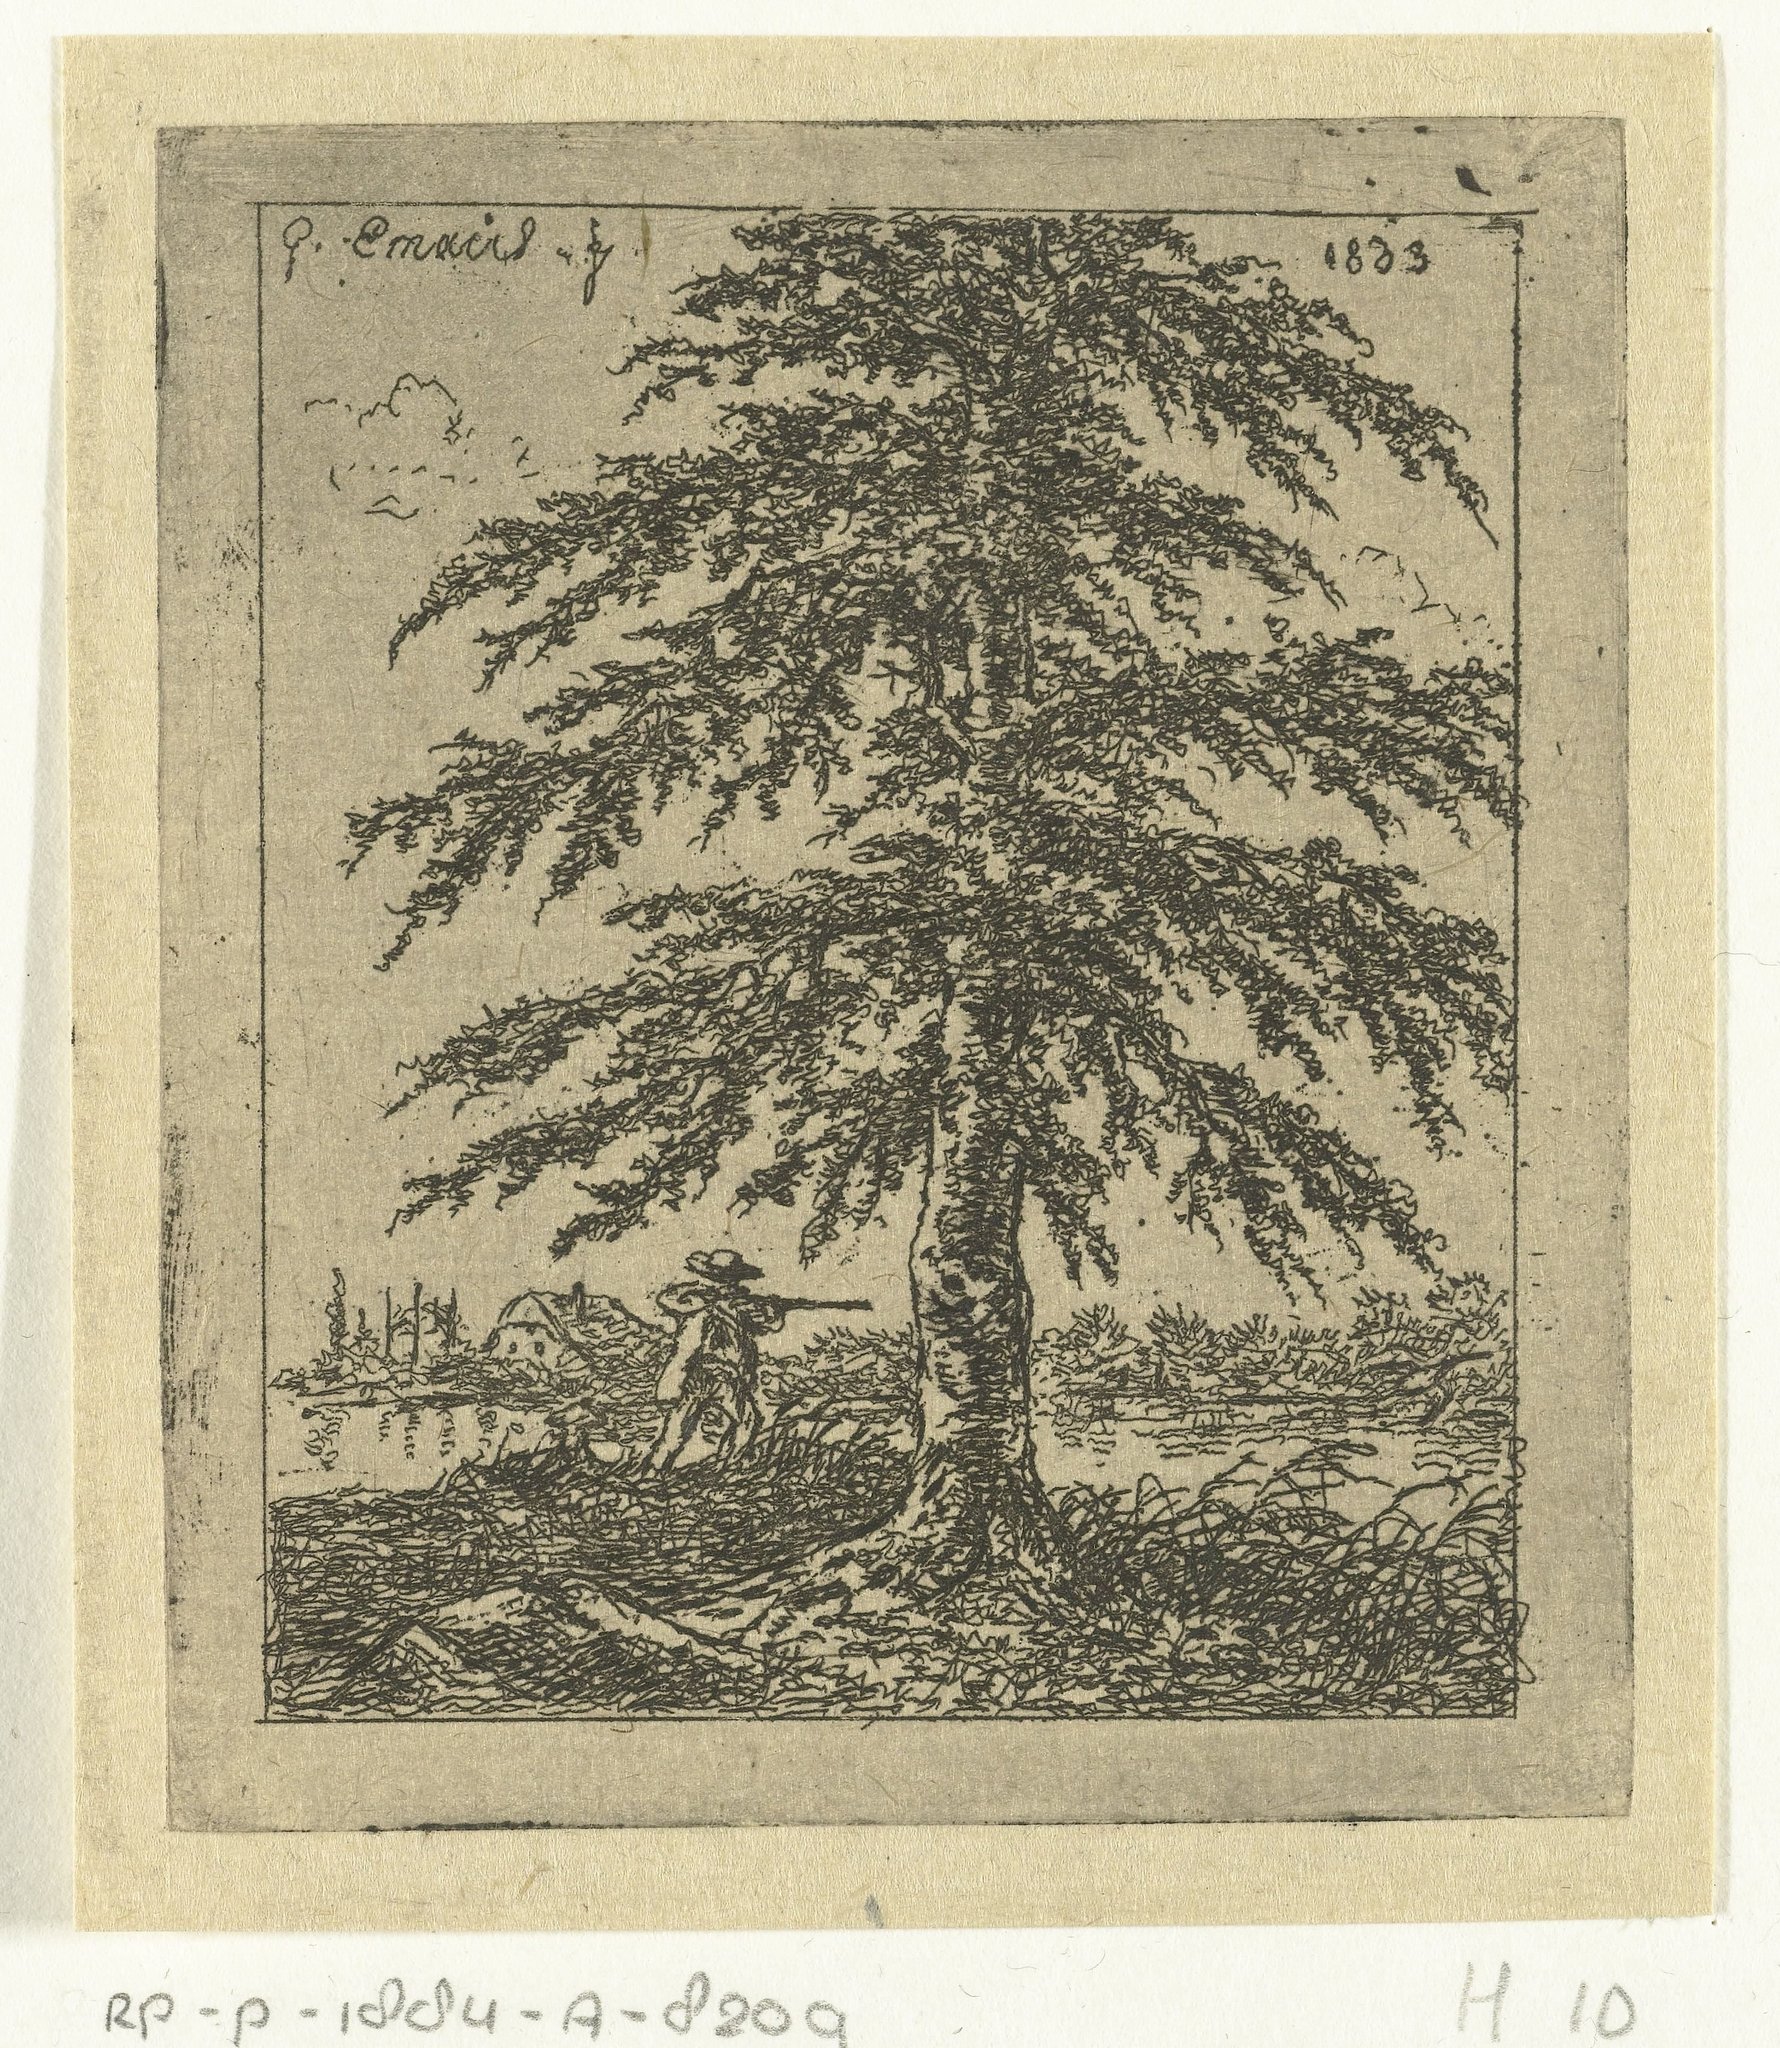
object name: print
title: Landschap met beuk en jager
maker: gerardus emaus de micault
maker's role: draughtsman, print maker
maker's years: 1798-1863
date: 1863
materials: paper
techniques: etching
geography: netherlands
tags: hunter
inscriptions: collector's mark: Lugt 2228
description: Onder een beuk richt een jager zijn geweer op een opvliegende eend. Op de achtergrond een boerderij aan het water.